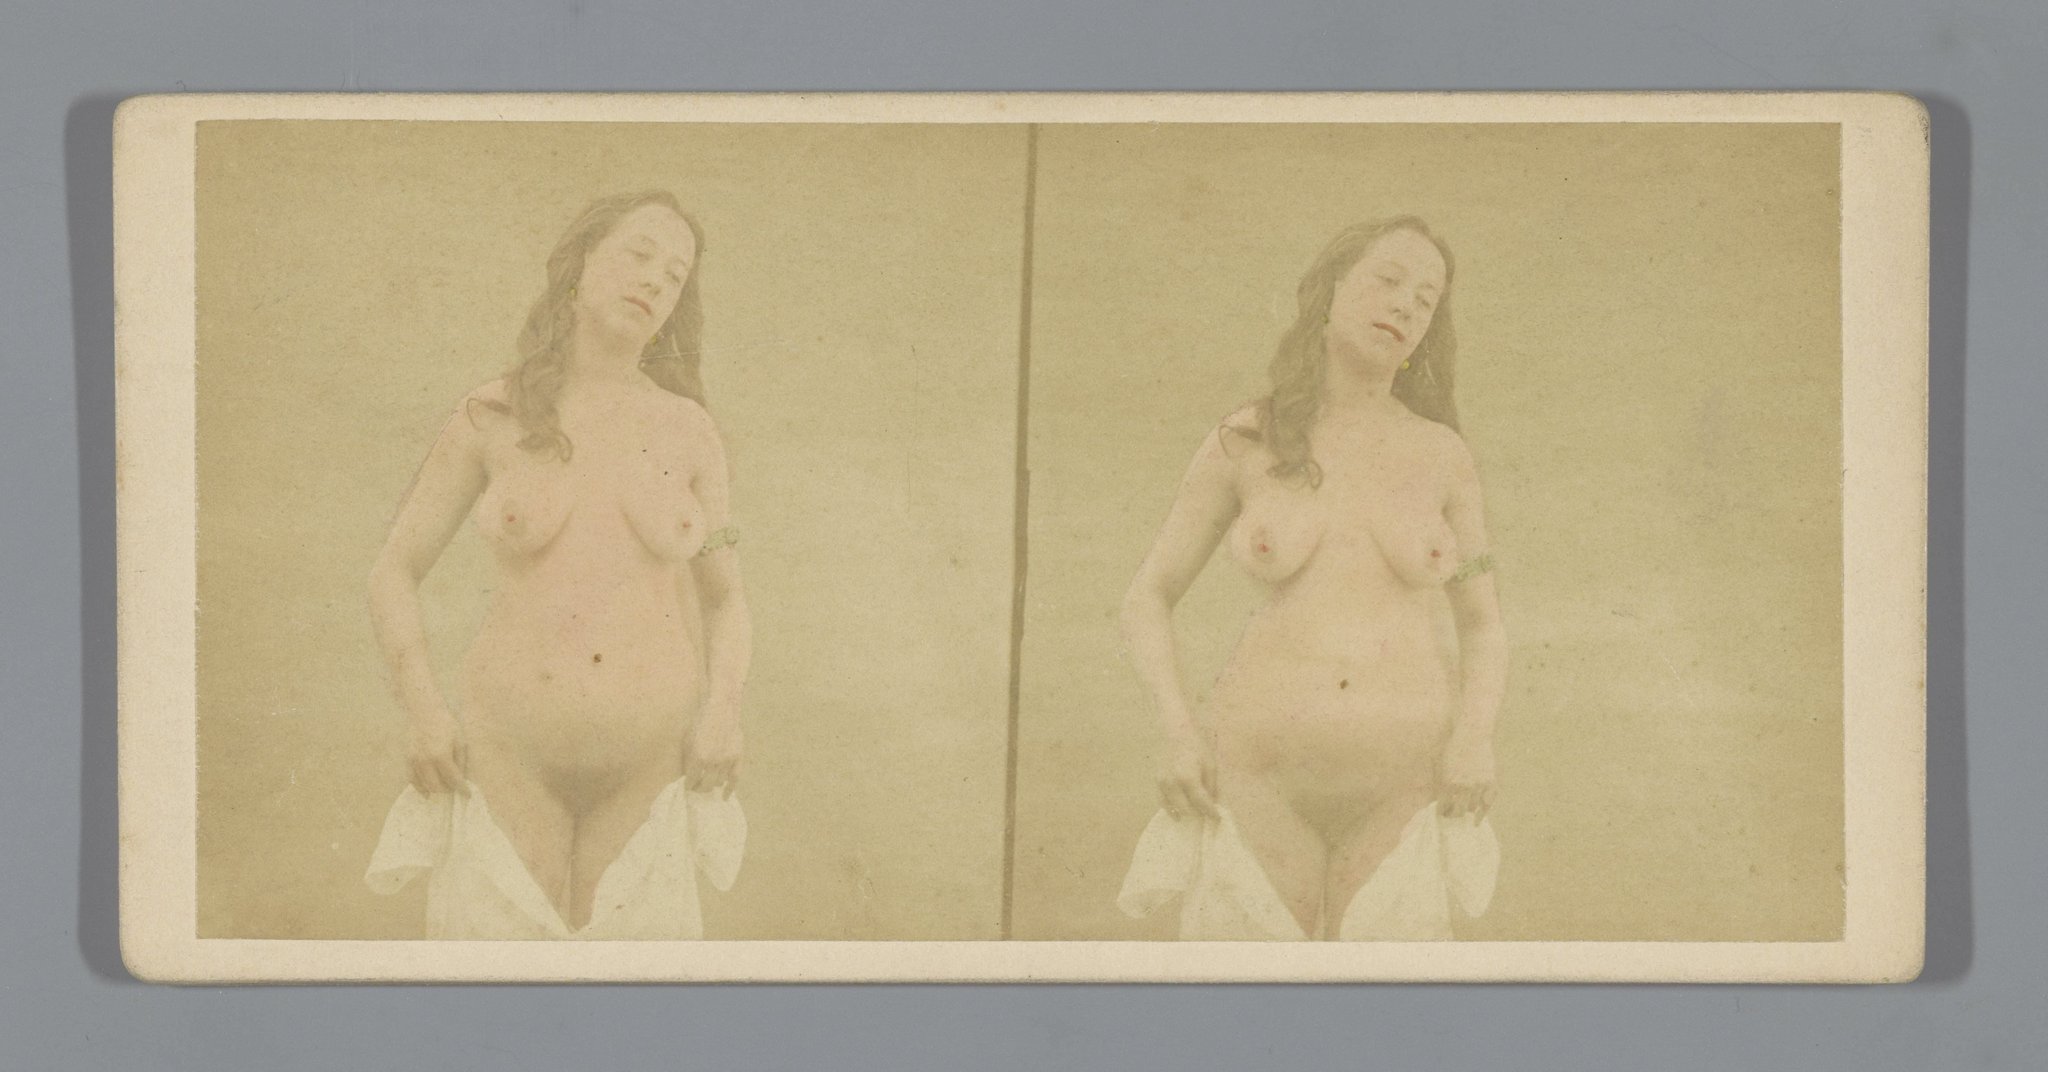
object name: stereograph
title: Portret van een naakte vrouw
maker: Anonymous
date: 1873-1890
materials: cardboard, paper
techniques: albumen print, hand coloring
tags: woman (showing herself) undressed, quasi-nude, anonymous historical person portrayed